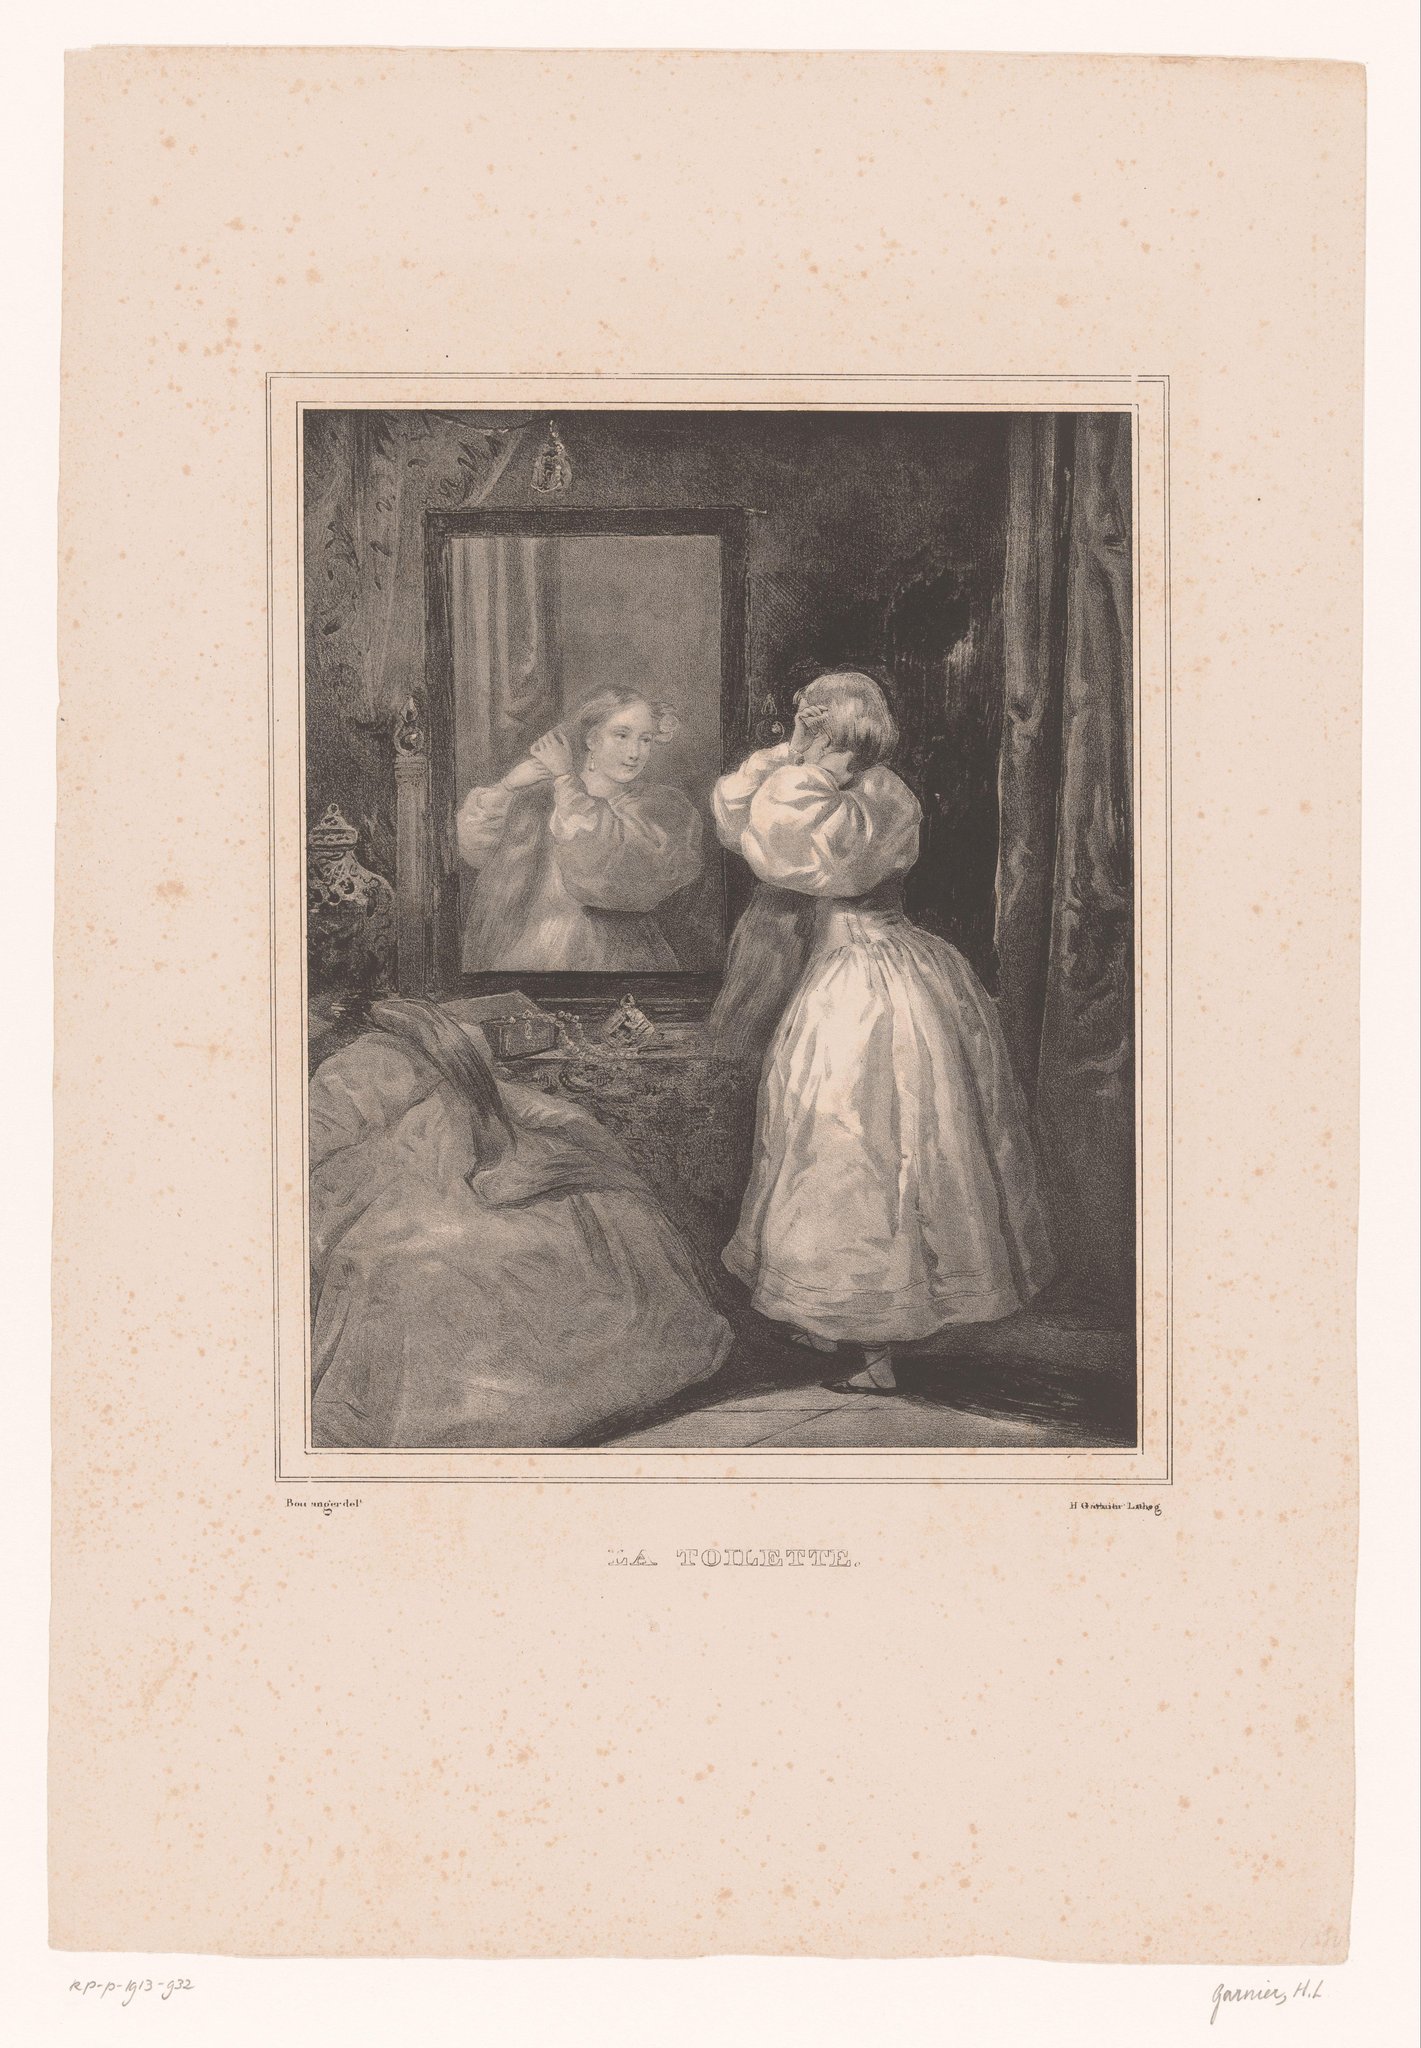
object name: print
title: La toilette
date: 1846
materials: paper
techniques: lithograph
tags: adolescent, young woman, maiden, comb, brush and other tools (care of the hair) - aa - ~ women, mirror - aa - (for) women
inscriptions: collector's mark: Lugt 2228a